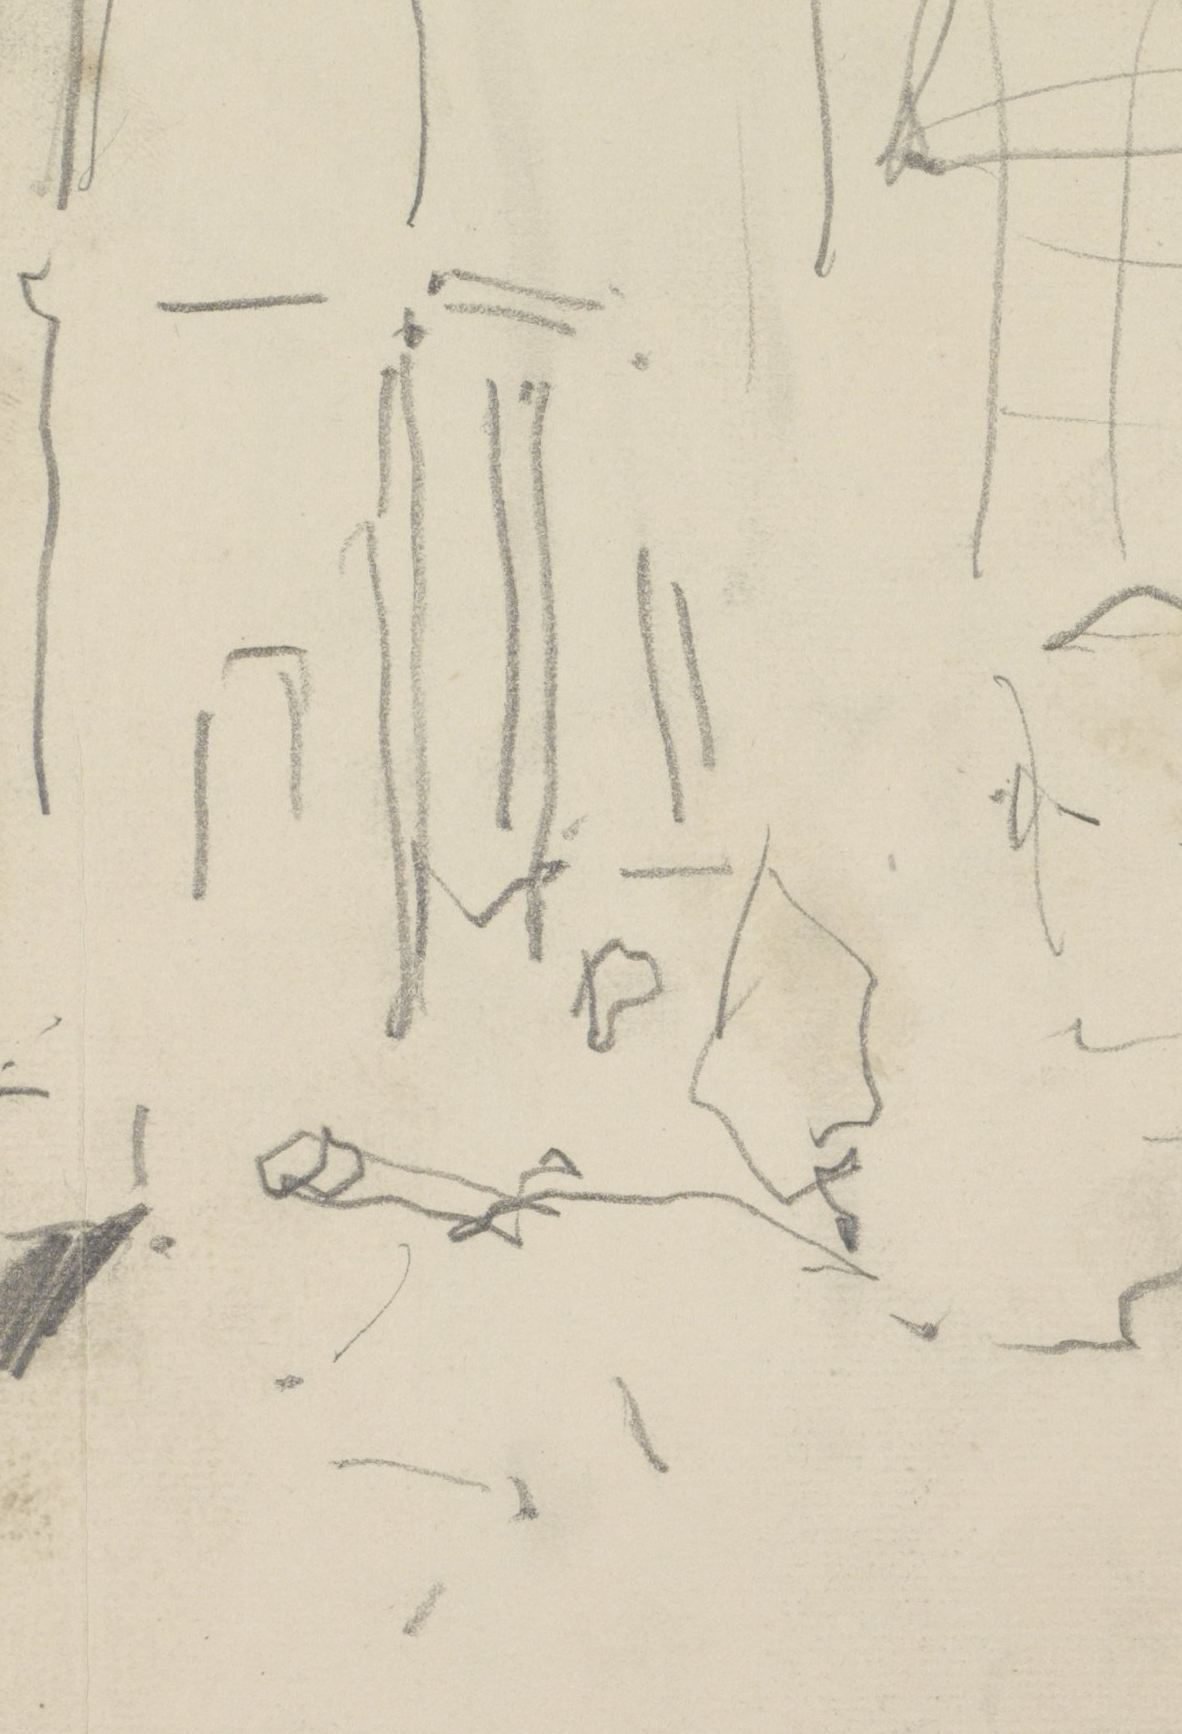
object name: sketchbook leaf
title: Gebouwen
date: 1881-1883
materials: paper, pencil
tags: city-view, and landscape with man-made constructions, civic architecture; edifices; dwellings, the hague, rotterdam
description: Pagina 23 uit een schetsboek met 19 bladen.